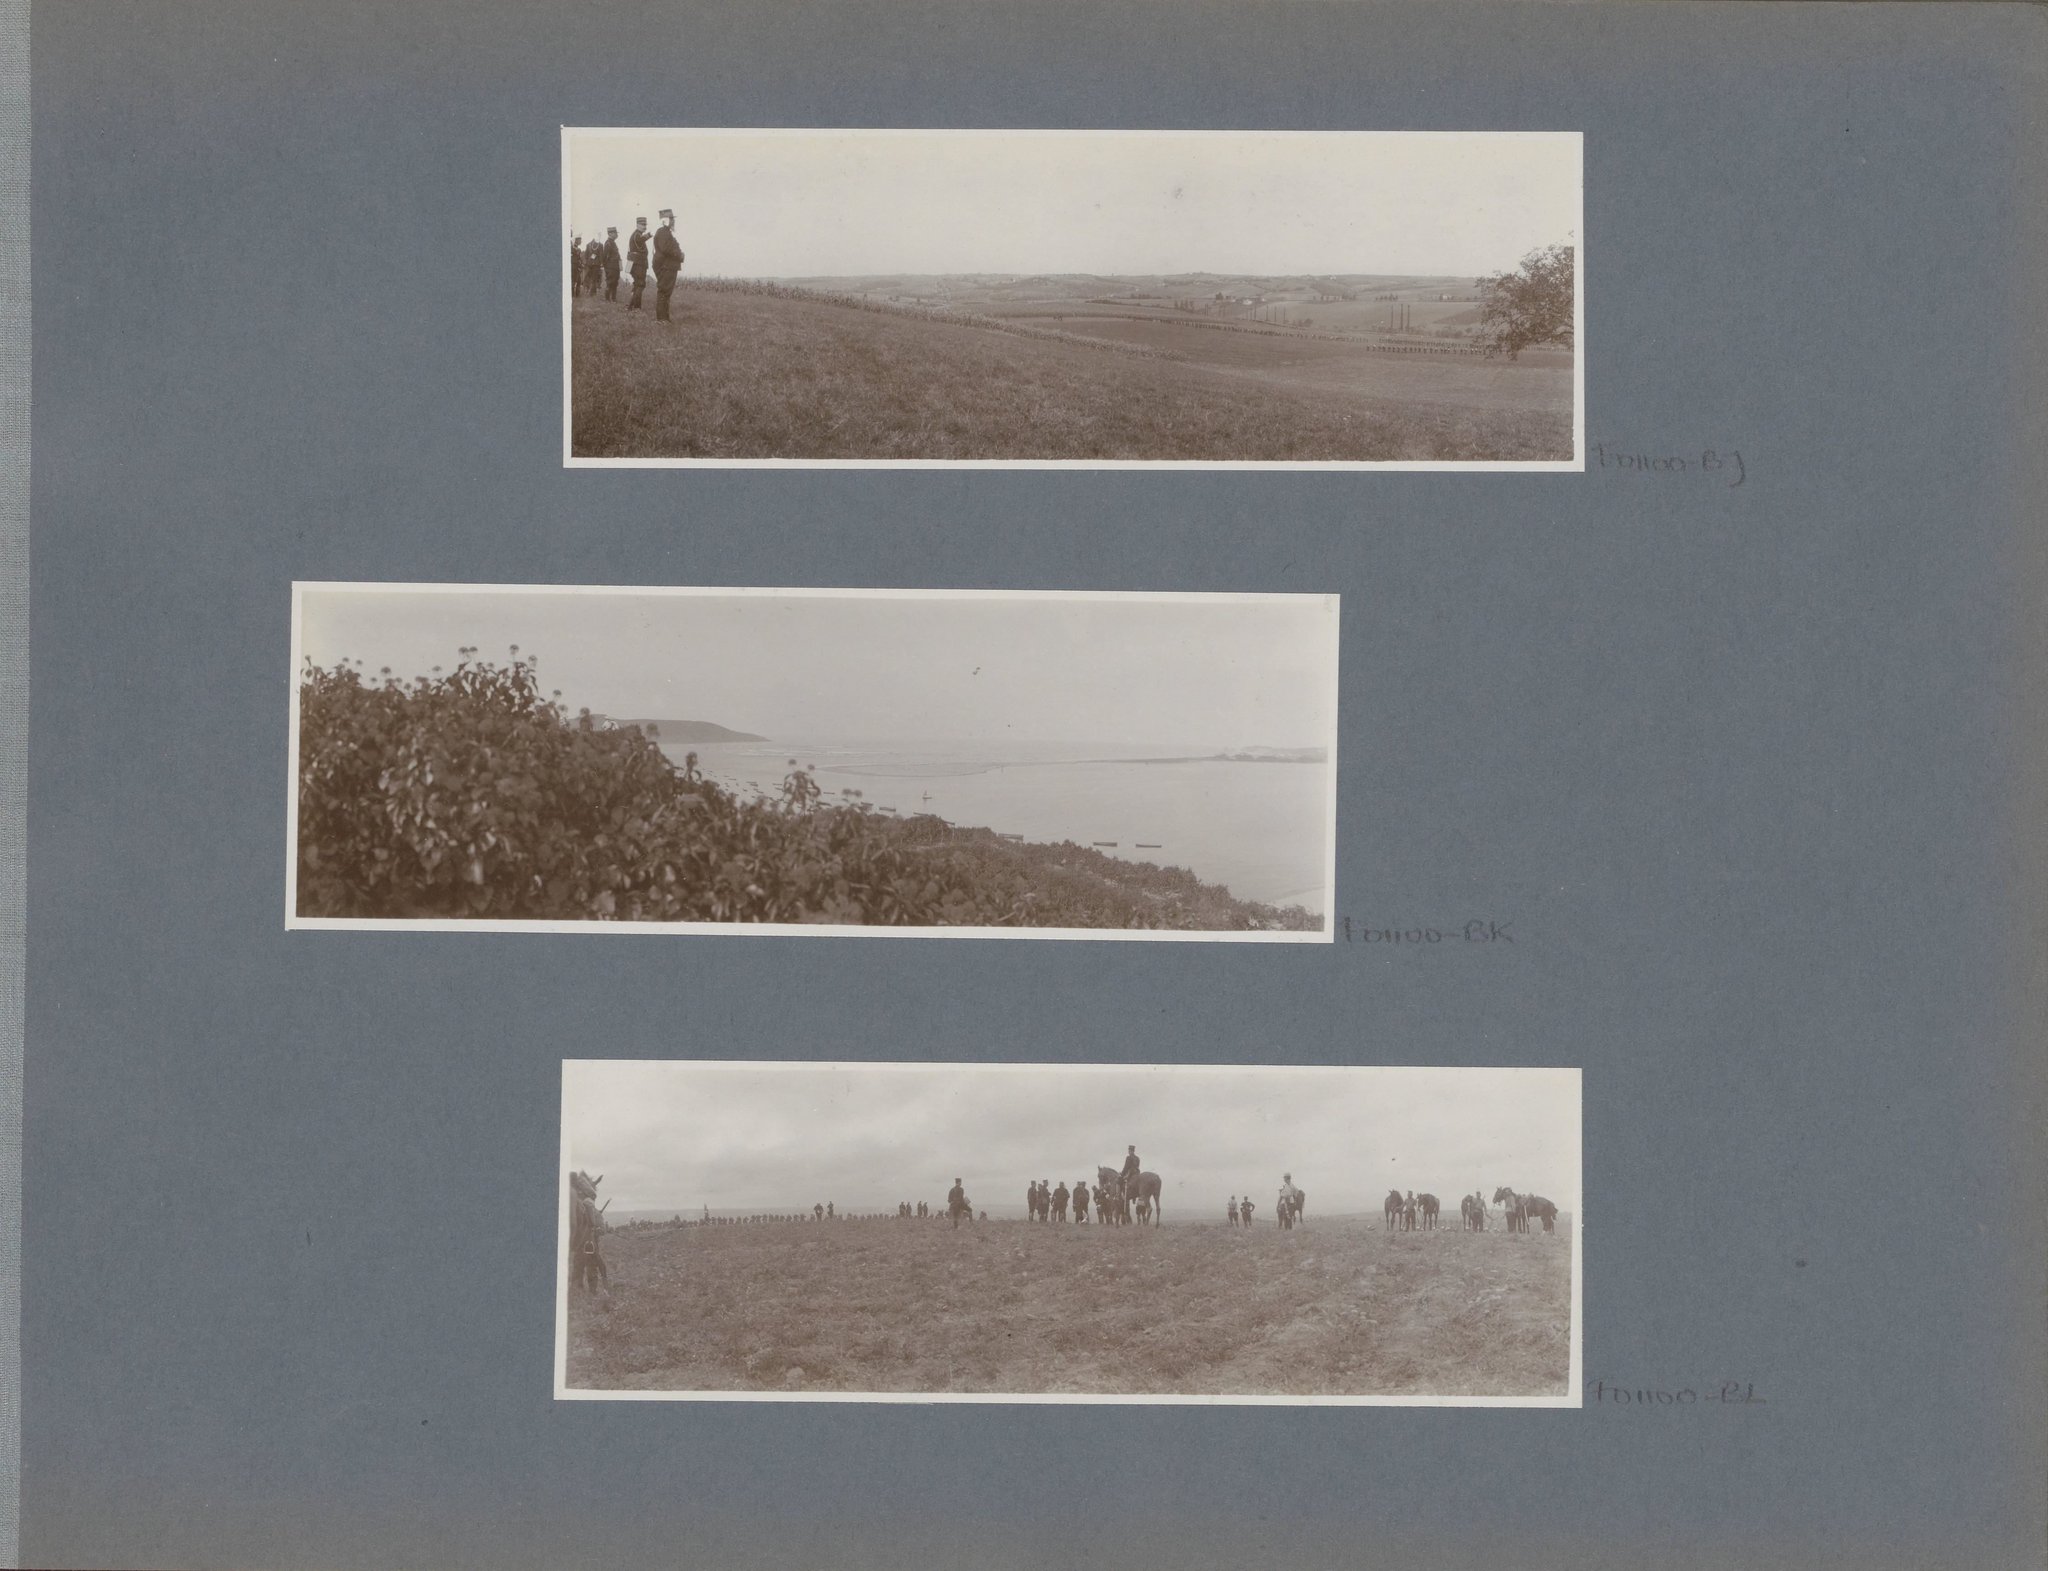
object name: album leaf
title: Militairen op een rij kijken toe bij veldmanoeuvres in Frankrijk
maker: Anonymous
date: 1902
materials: paper, photographic support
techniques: daylight paper print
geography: france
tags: manoeuvre ~ military training, land forces, france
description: Onderdeel van Fotoalbum van een legeroefening in Zuidwest-Frankrijk in 1902.